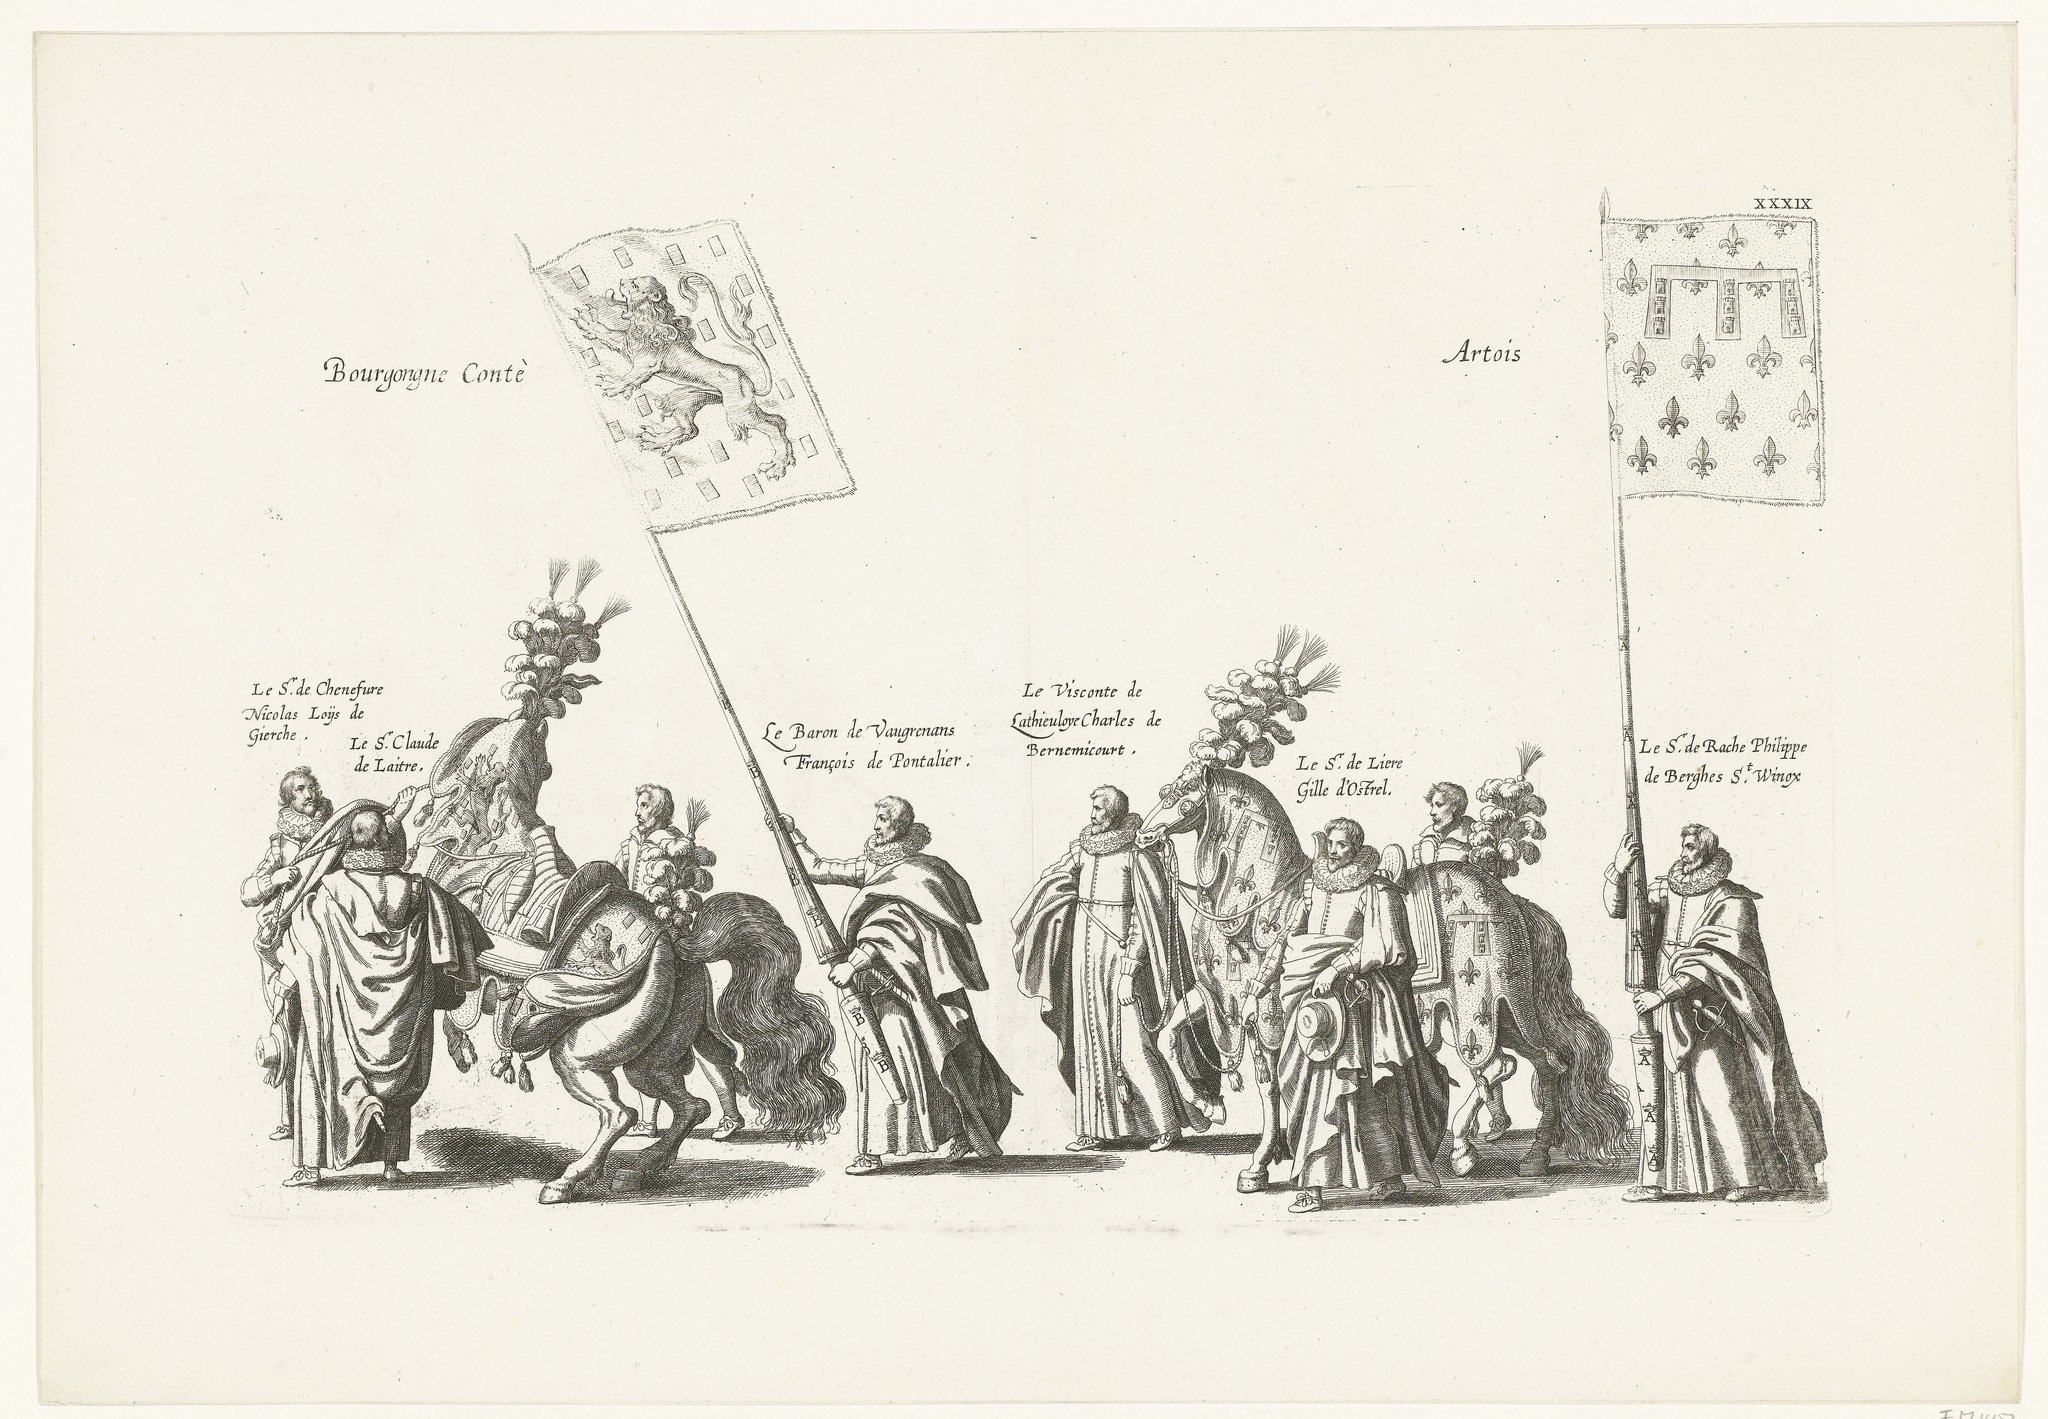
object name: print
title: Pompa funebris optimi potentissimiq. principis Alberti pii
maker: cornelis galle (i)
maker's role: print maker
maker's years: 1576-1650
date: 1623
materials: paper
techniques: etching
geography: southern netherlands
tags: brussels, albrecht aartshertog van oostenrijk, cortege, funeral procession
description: Deelnemers in de begrafenisstoet met de vaandels van Bourgogne-Franche-Comté en Artesië. Plaat XXXVIII in de serie van de begrafenis van aartshertog Albrecht van Oostenrijk te Brussel op 12 maart 1622.